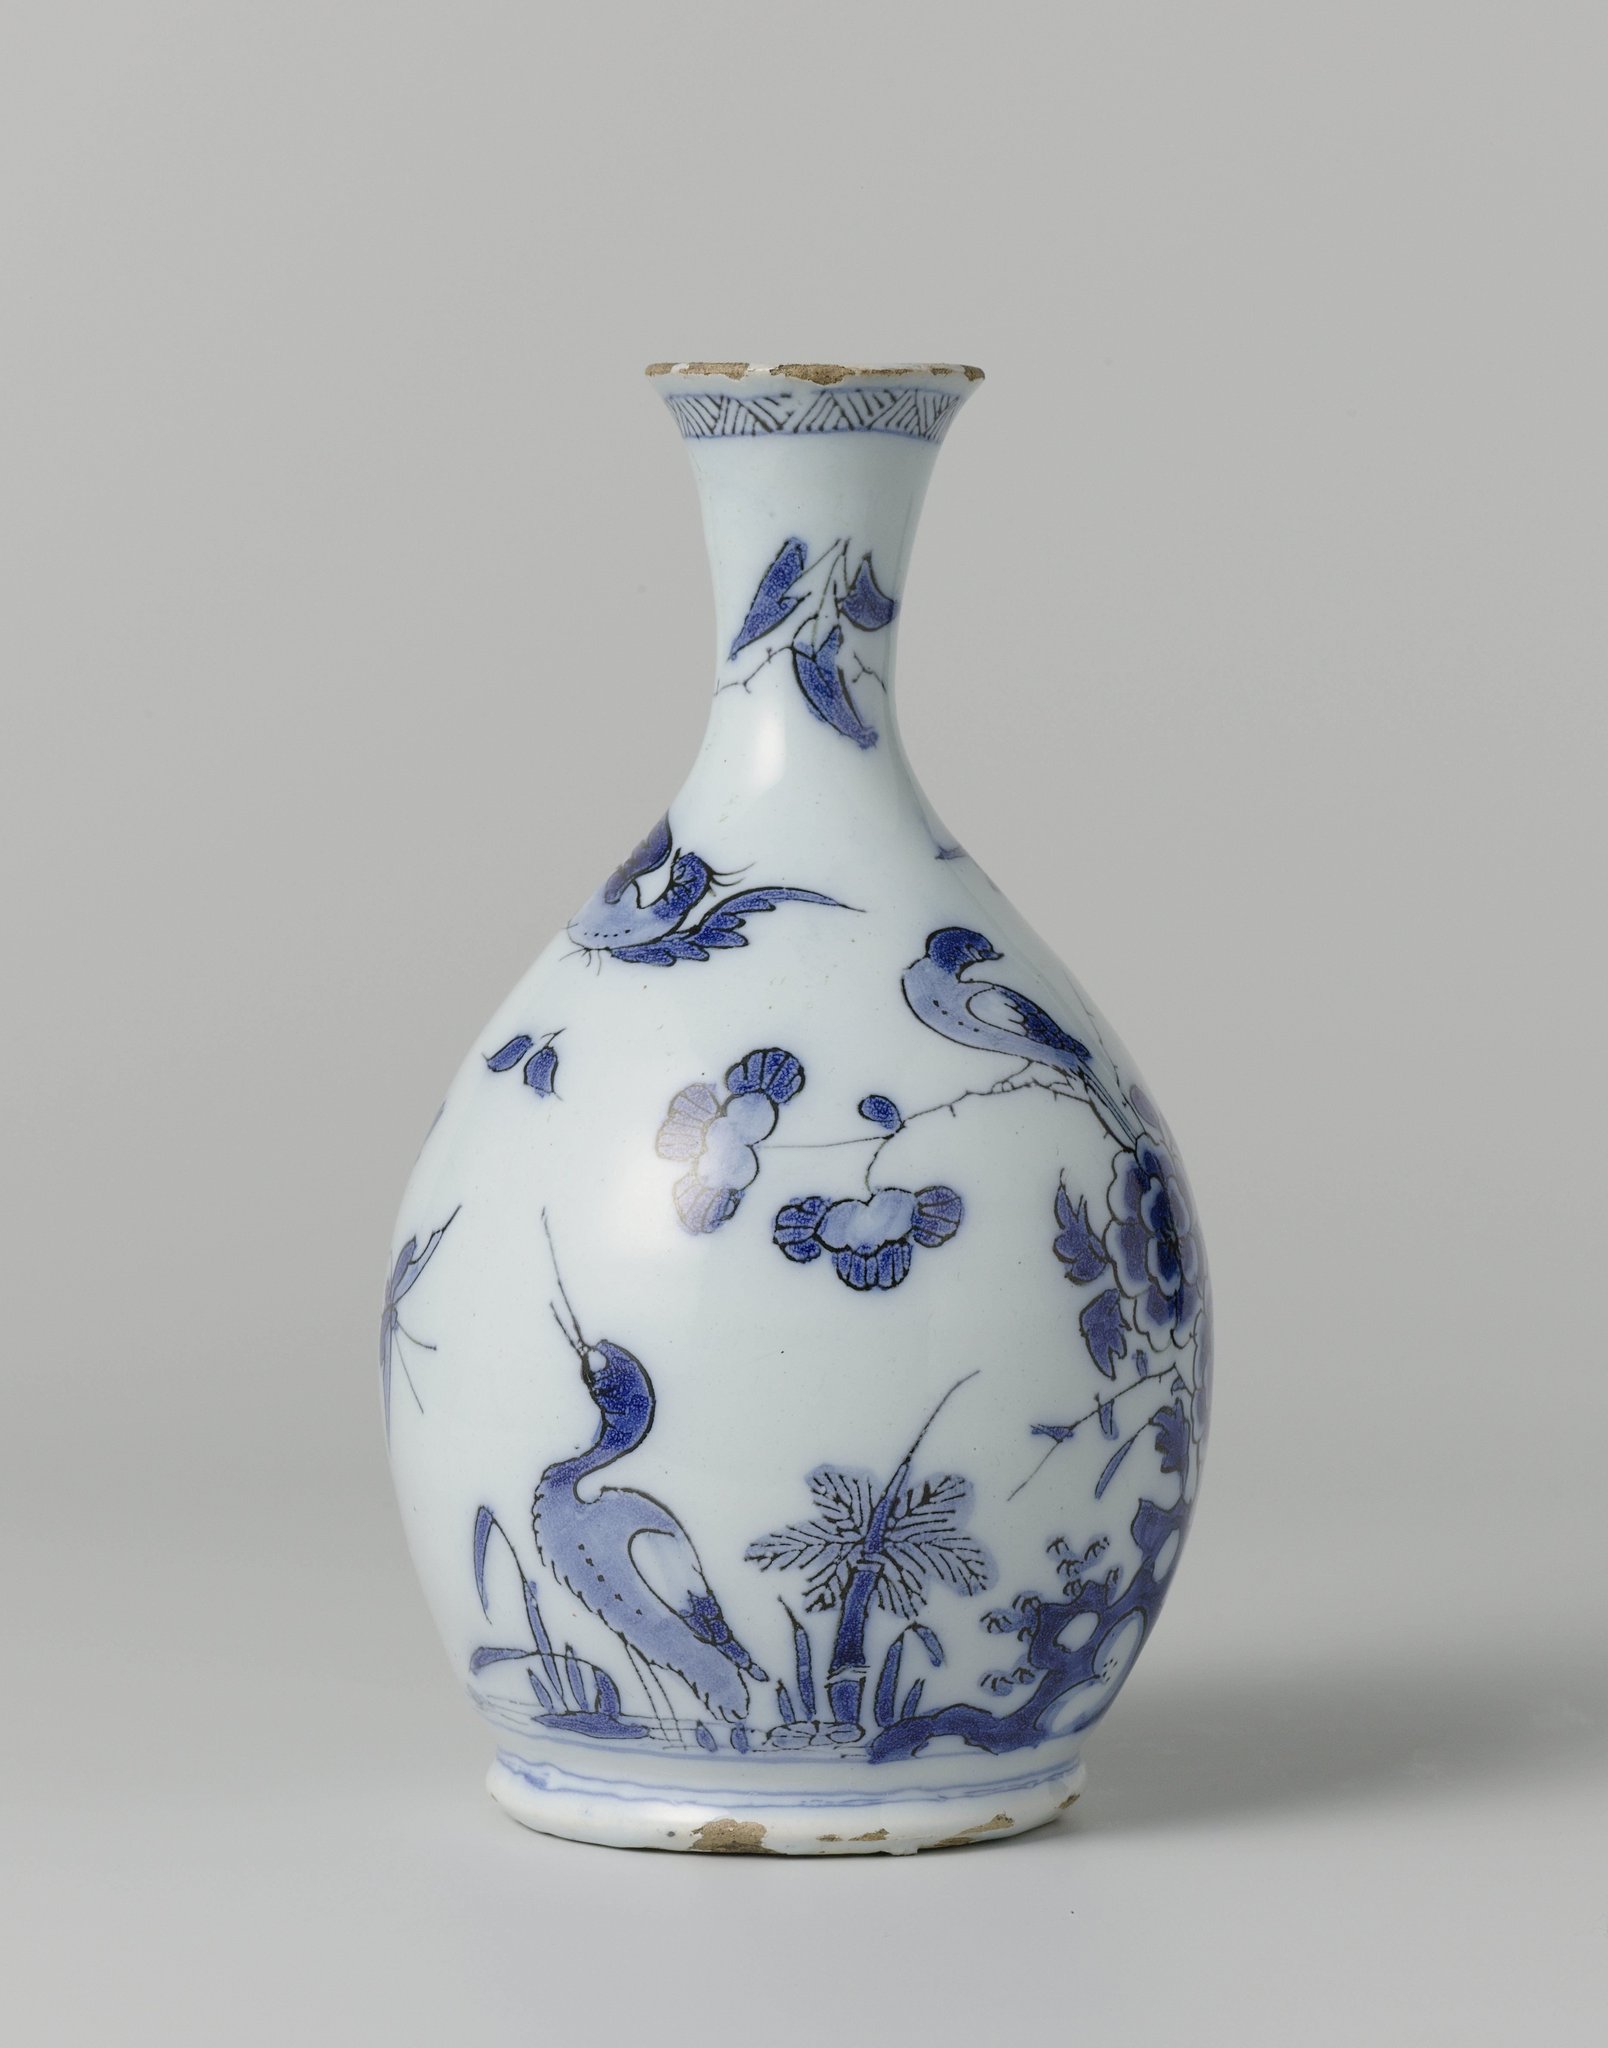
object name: vase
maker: rochus jacobsz. hoppesteijn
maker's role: plateelbakker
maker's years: -1692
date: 1685-1690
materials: earthenware, glaze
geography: delft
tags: birds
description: Vaas van faience met op het Chinese porselein geïnspireerde bloemen. Delfts aardewerk, gemerkt RS.